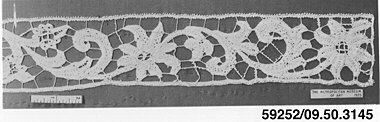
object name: strip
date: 1667-1700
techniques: lace